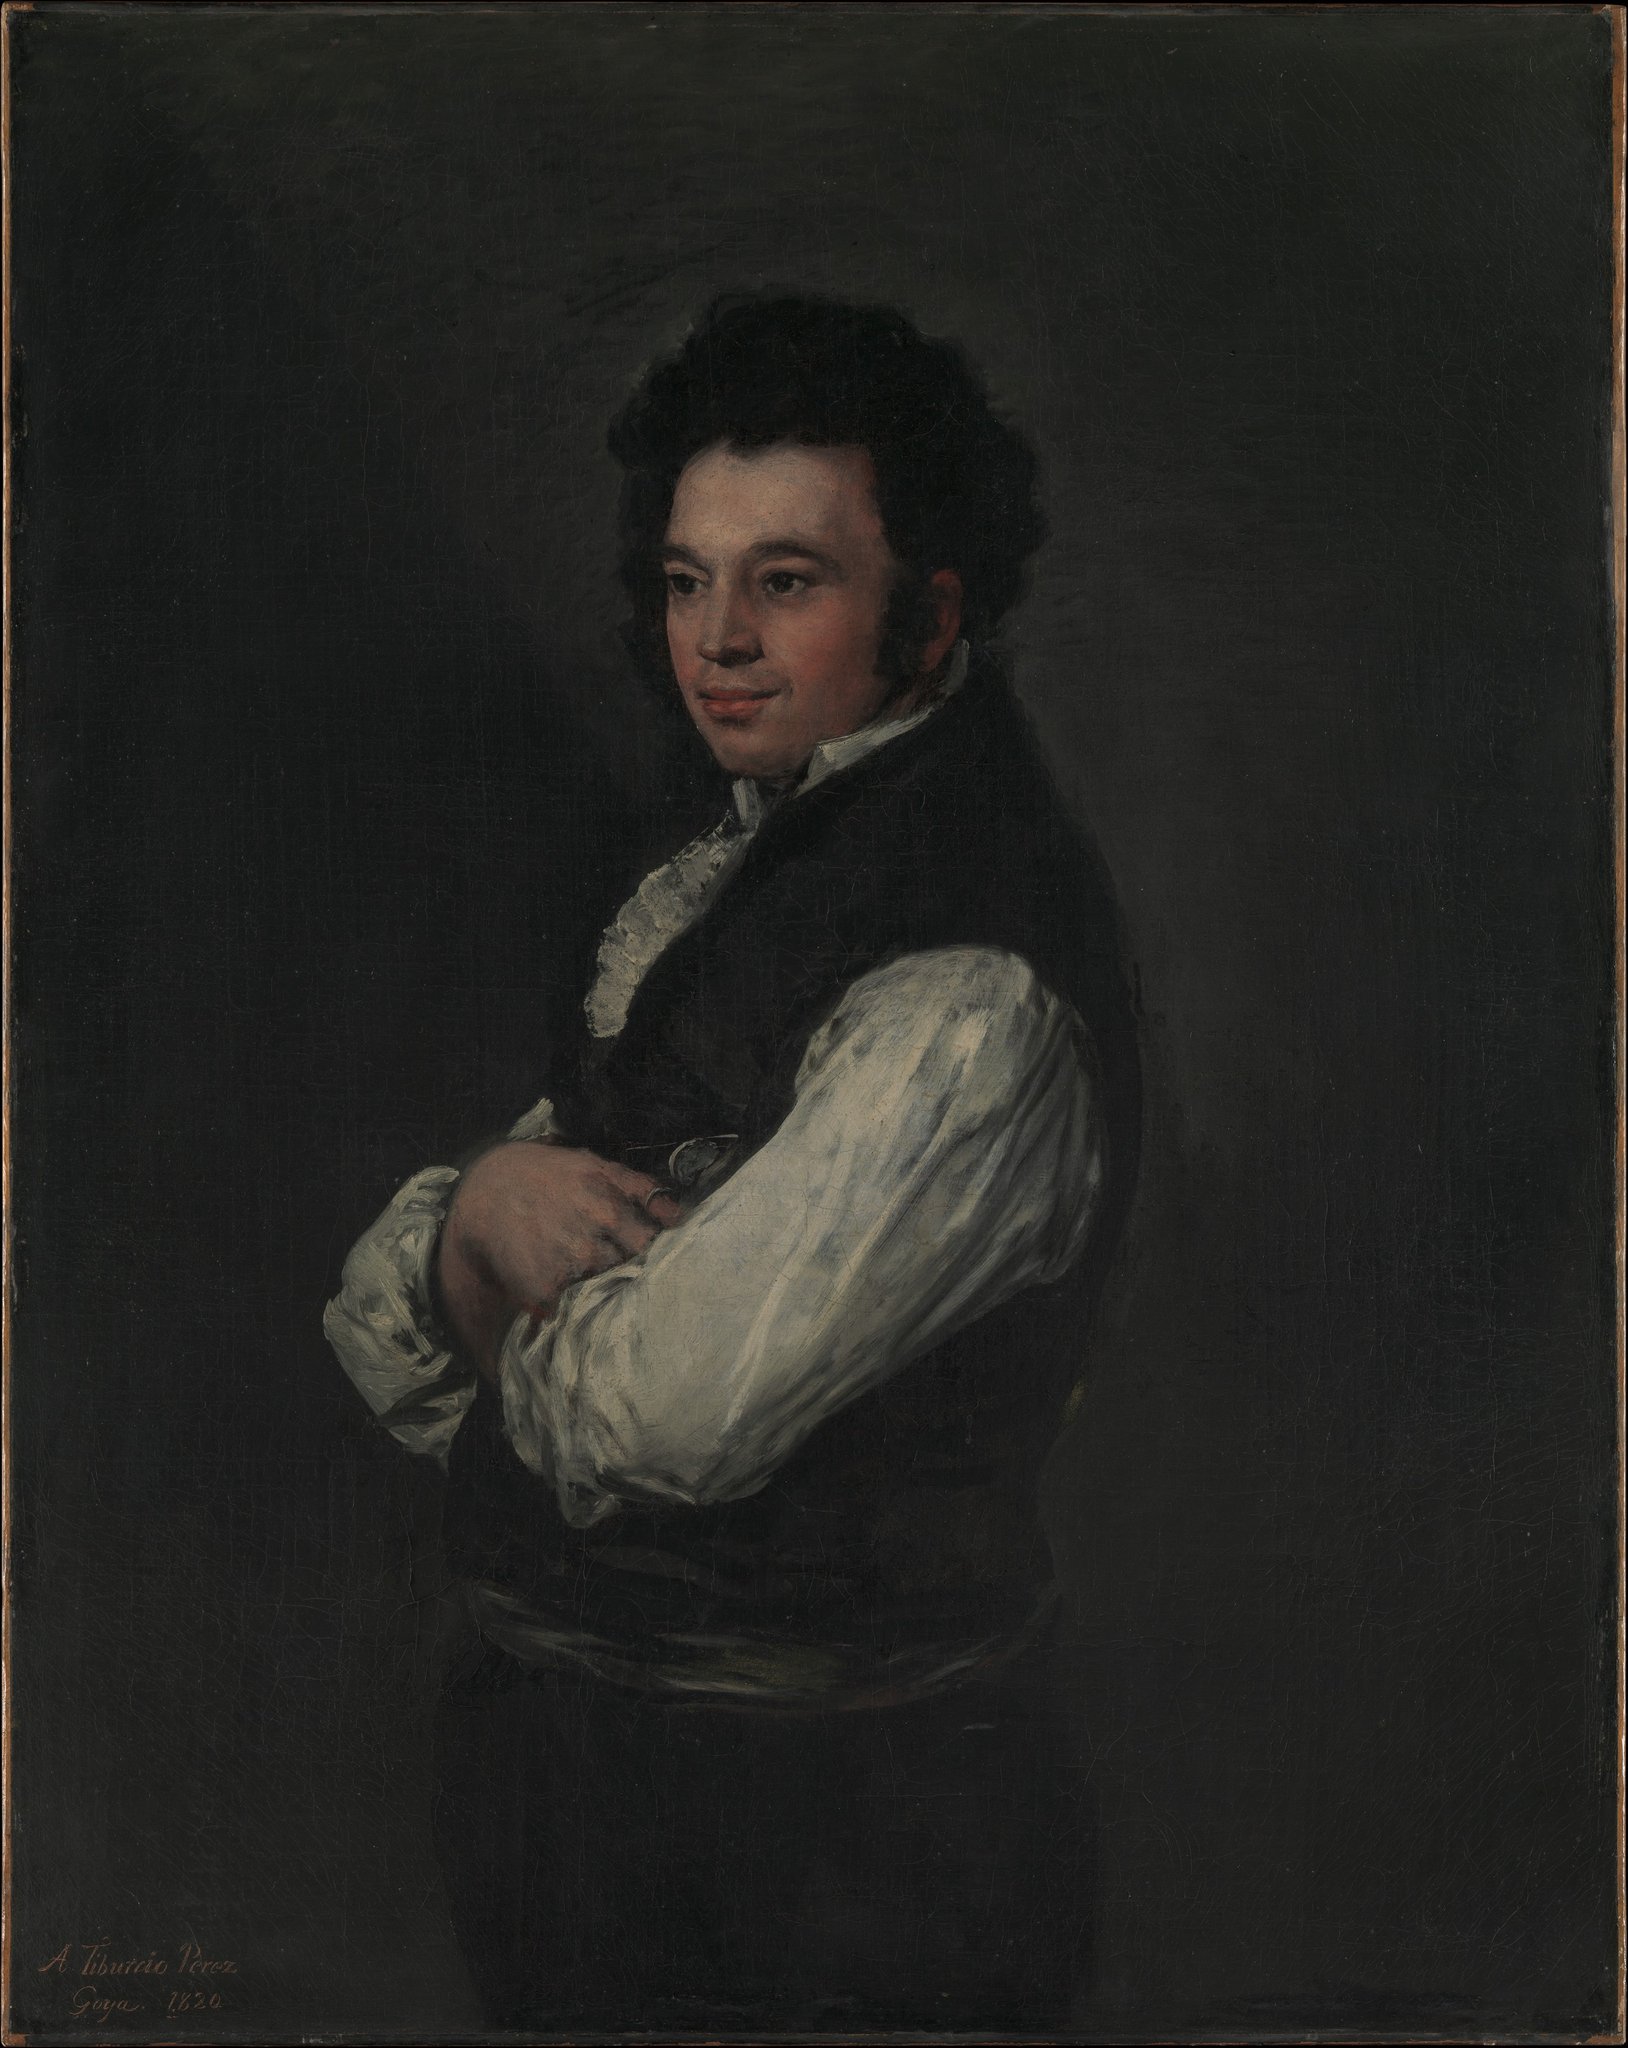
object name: painting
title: Tiburcio Pérez y Cuervo (1785/86–1841), the Architect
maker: goya (francisco de goya y lucientes)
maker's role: artist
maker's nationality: spanish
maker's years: 1746-1828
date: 1820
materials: canvas, oil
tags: men,portraits,architects